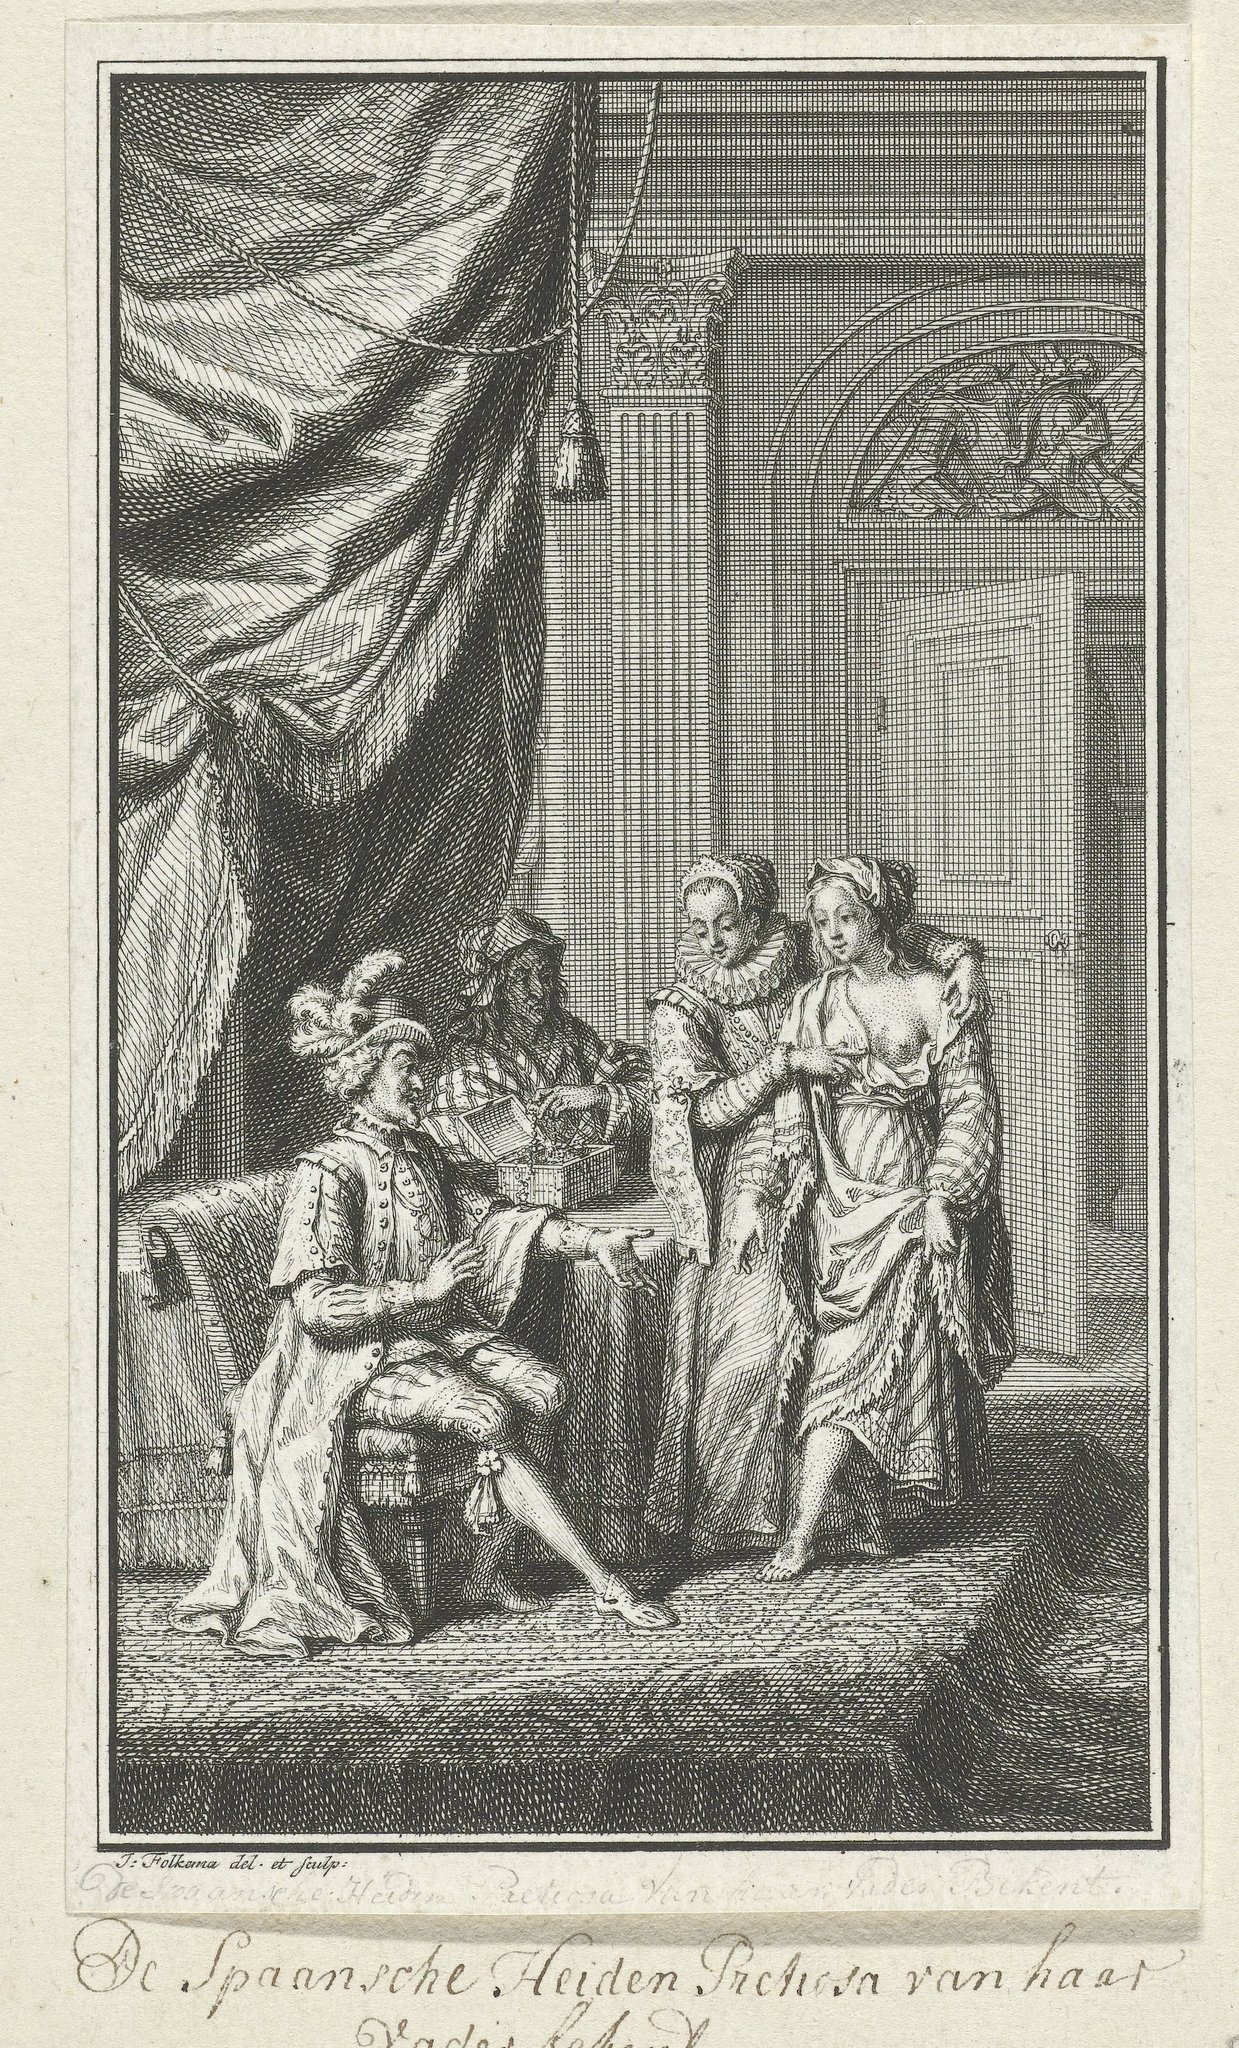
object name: print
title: Het Spaanse heidinnetje Preciosa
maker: jacob folkema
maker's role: draughtsman, print maker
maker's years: 1692-1767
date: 1702-1767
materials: paper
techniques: etching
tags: wandering communities: romani or roma, preciosa, whore, prostitute, hand uncovering the chest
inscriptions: inscription: ‘De Spaansche Heiden Pretiosa van haar Vader bekent’, collector's mark: Lugt 2228, inscription: ‘De Spaansche Heiden Pretiosa van haar Vader bekent’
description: De Spaanse heidin Preciosa staat voor een rijk geklede man. Een vrouw ontbloot een borst van Preciosa. Achter dit drietal steelt een oudere vrouw sierraden uit een kistje dat voor haar op tafel staat. Het Spaanse heidinnetje Preciosa en de vrouw zijn figuren ontleend aan het verhaal ‘La Gitanella’ van Miguel de Cervantes uit 1613, in Nederland bekend als ‘Het Spaans Heidinnetje’. Heiden en heidin waren eigentijdse benamingen voor het Roma-volk.